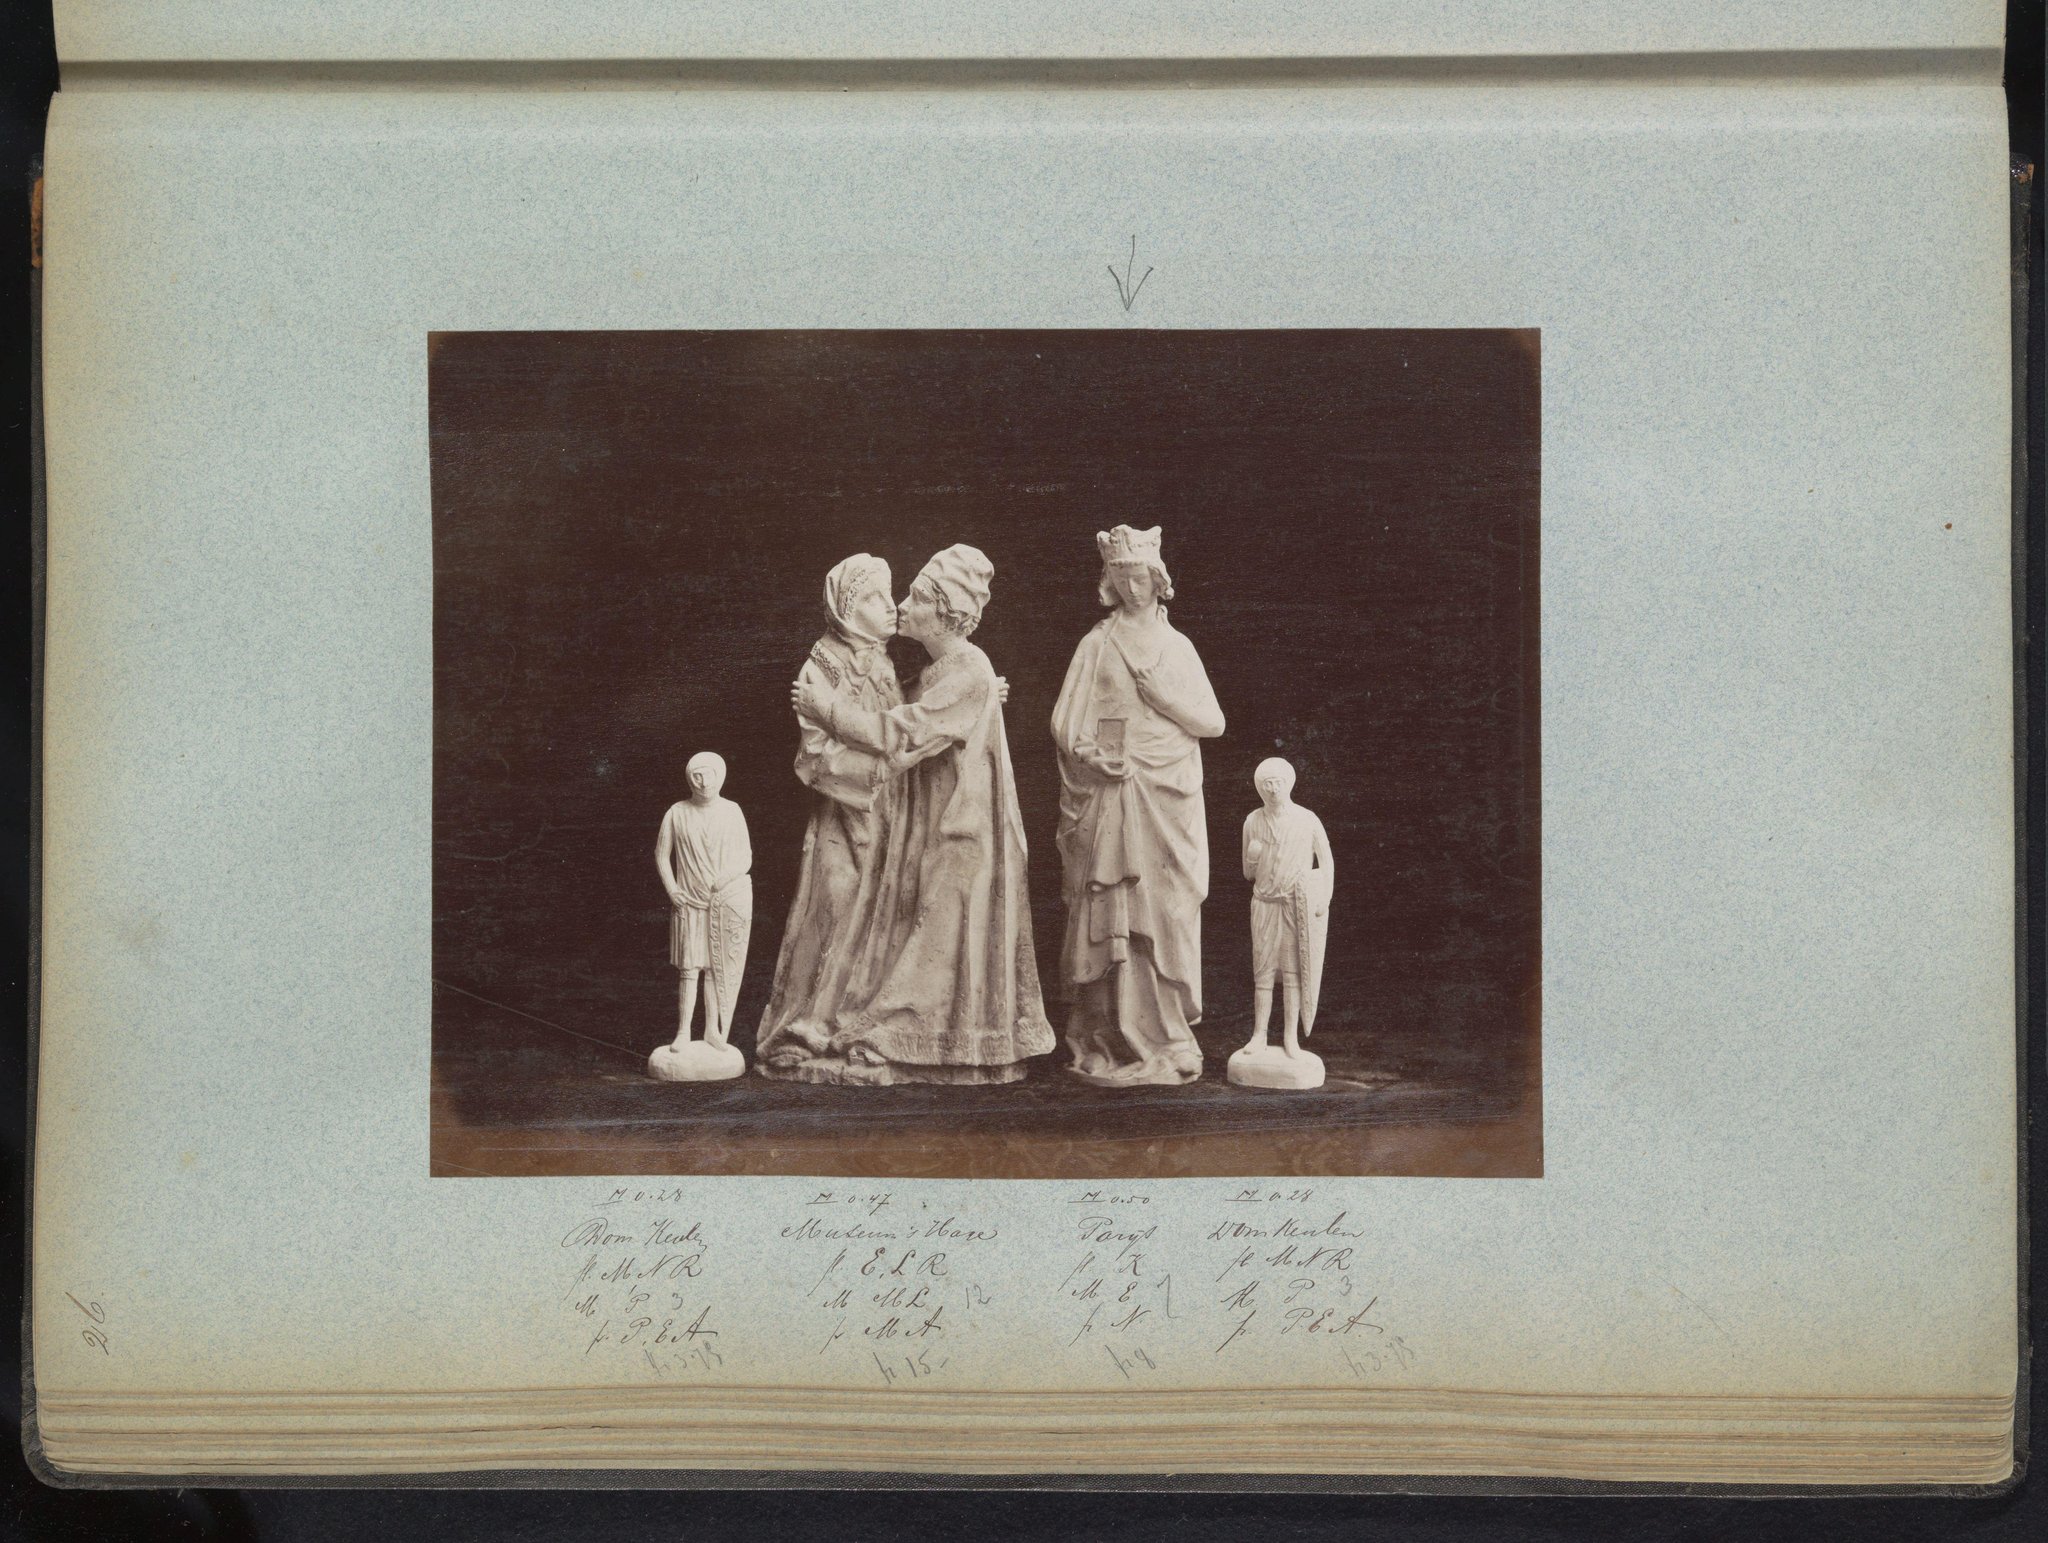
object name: album leaf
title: Vier gipsen afgietsels van sculpturen waarvan twee uit de Dom van Keulen te Duitsland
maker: Anonymous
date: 1875-1900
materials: paper, photographic support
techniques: albumen print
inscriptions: annotation, annotation: ‘M 0.28 M 0.47 M 0. 50 M 0.28’